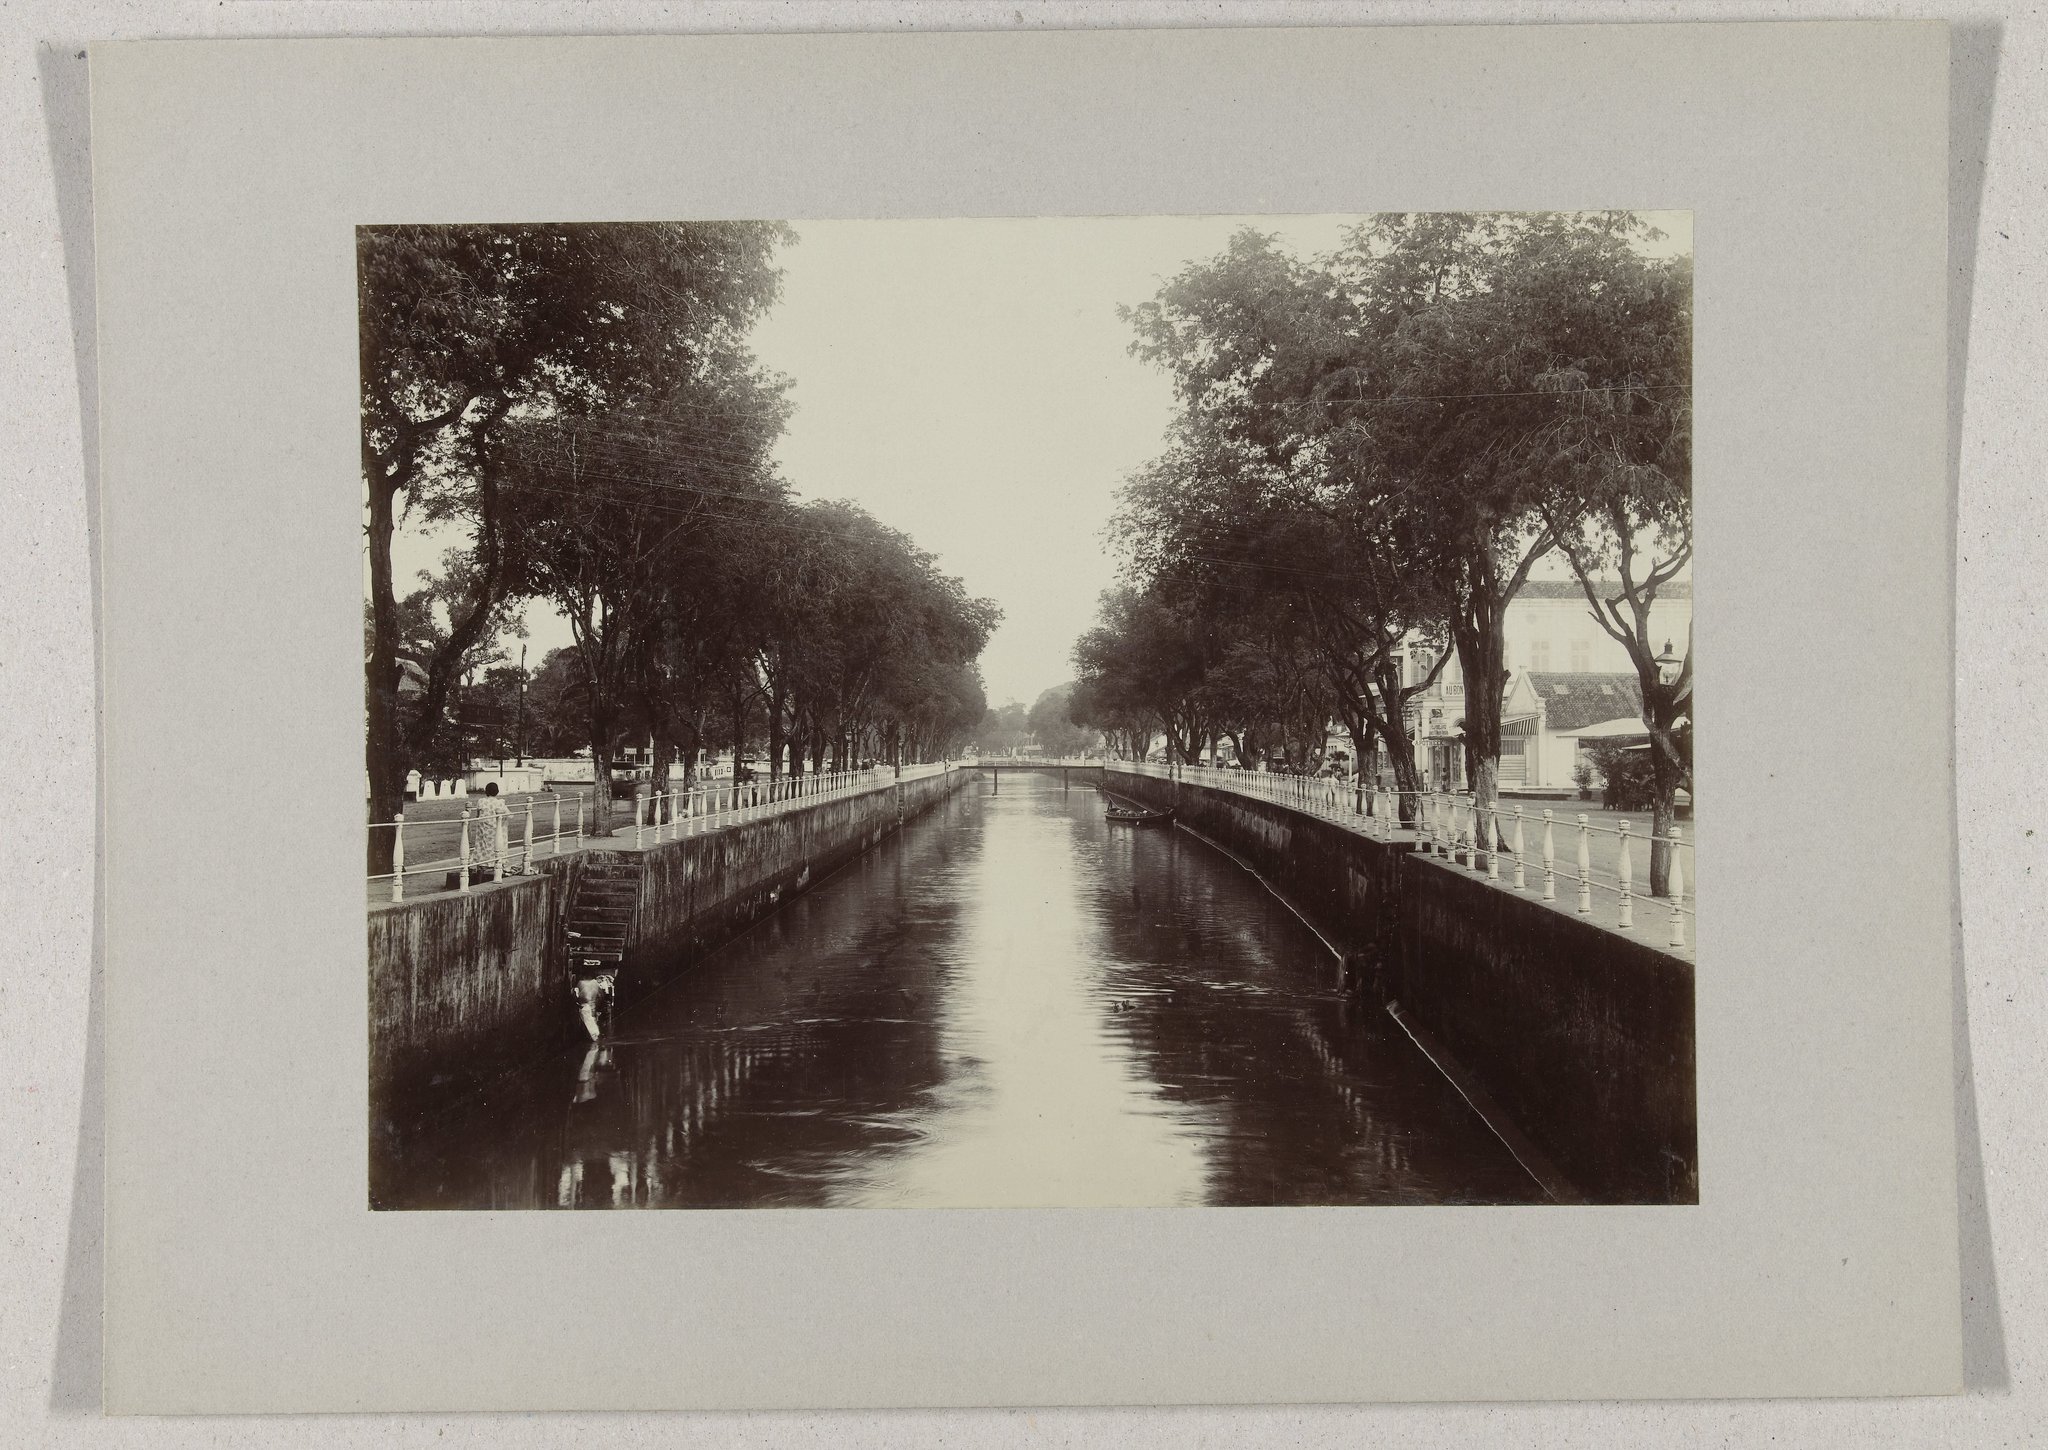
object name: photograph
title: Gezicht op Molenvliet in Batavia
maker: Anonymous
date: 1895-1915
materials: cardboard, paper, photographic support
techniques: gelatin silver print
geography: batavia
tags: indonesia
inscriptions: annotation: ‘42. Molenvliet (l Noordwijk; r Rijswijck)’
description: Gezicht op Molenvliet, Batavia (Jakarta), Java, Nederlands-Indië